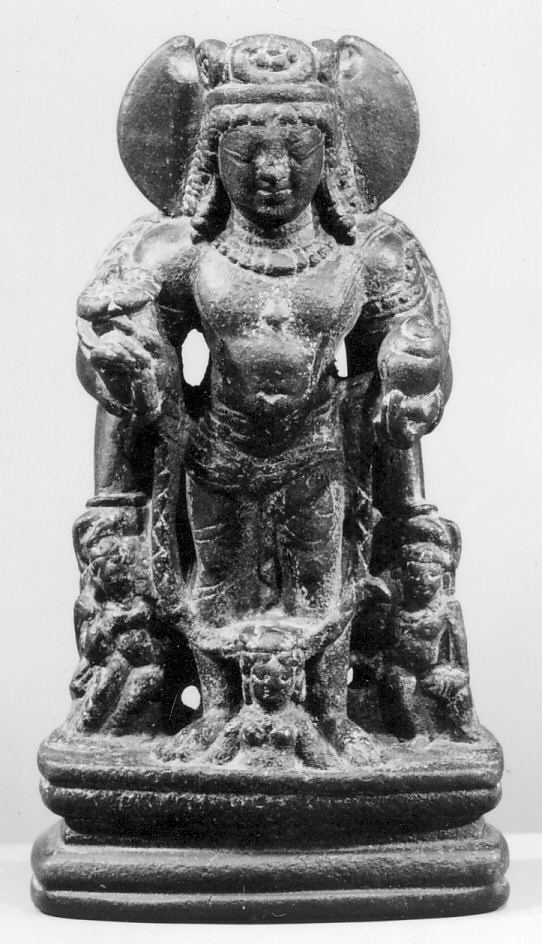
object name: figure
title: Standing Vishnu Flanked by Attendants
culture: kashmiri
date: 801-900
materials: limestone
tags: human figures,kashmir,vishnu,hinduism